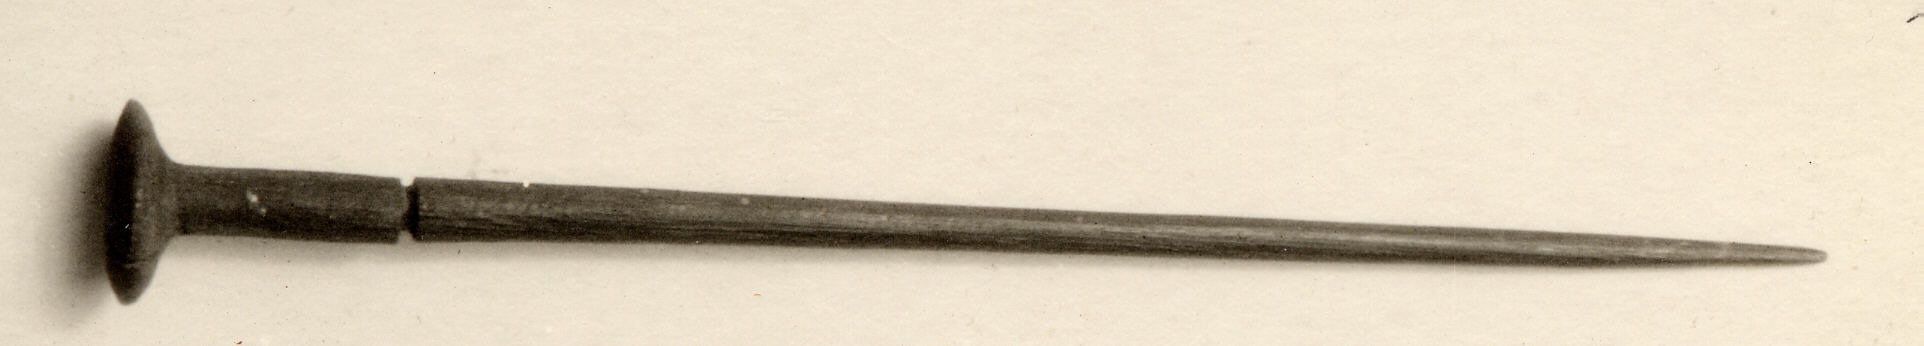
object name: hairpin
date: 2030-1640 BCE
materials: wood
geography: egypt